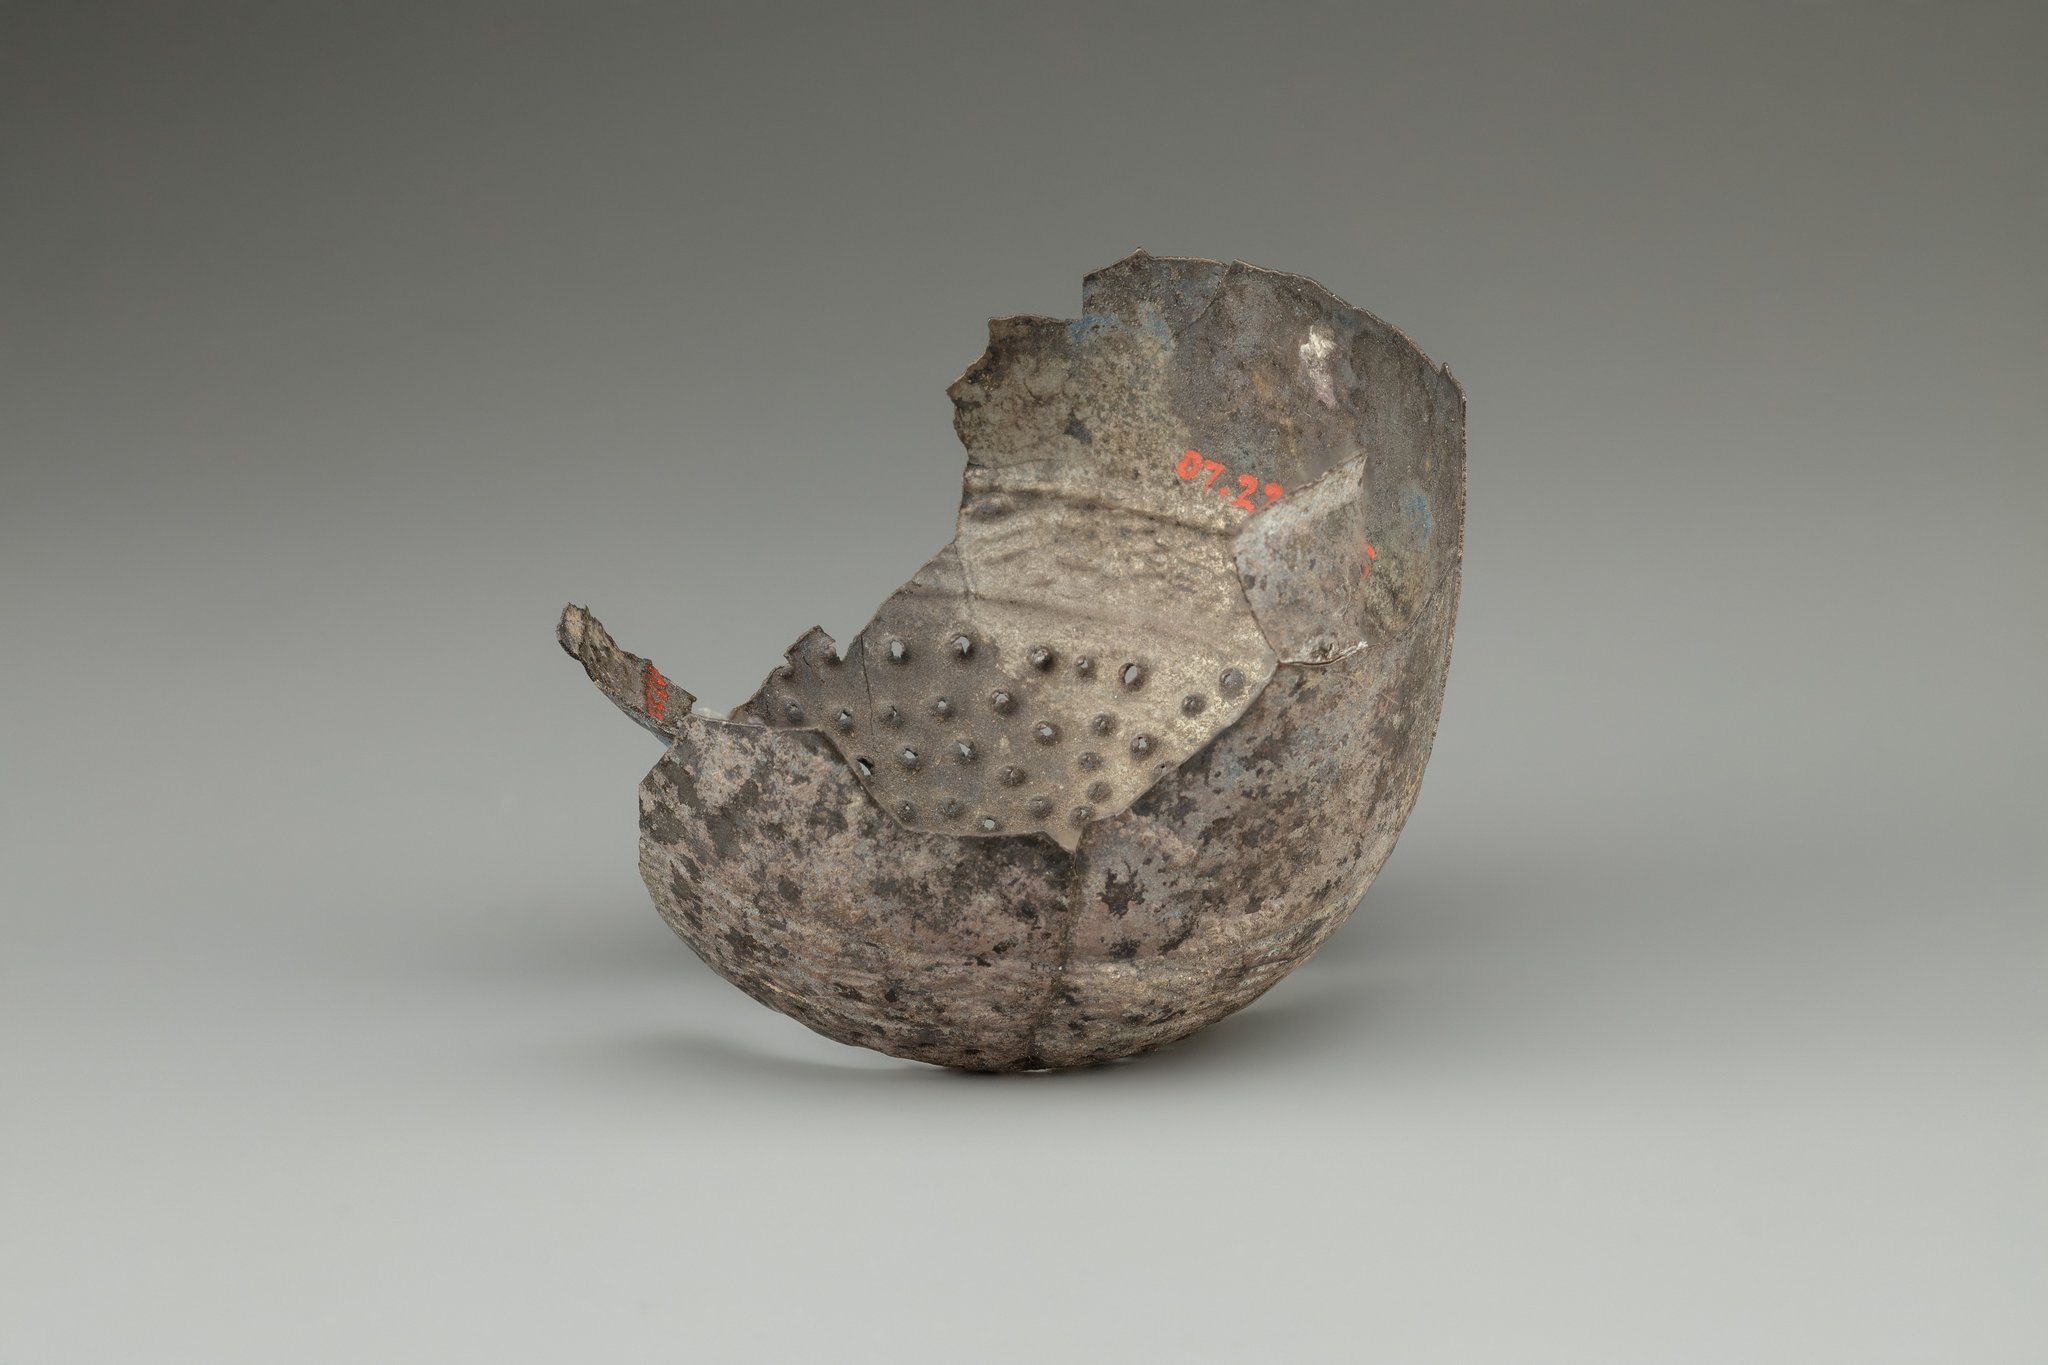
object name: strainer or vase fragment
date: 1295-1070 BCE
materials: silver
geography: egypt